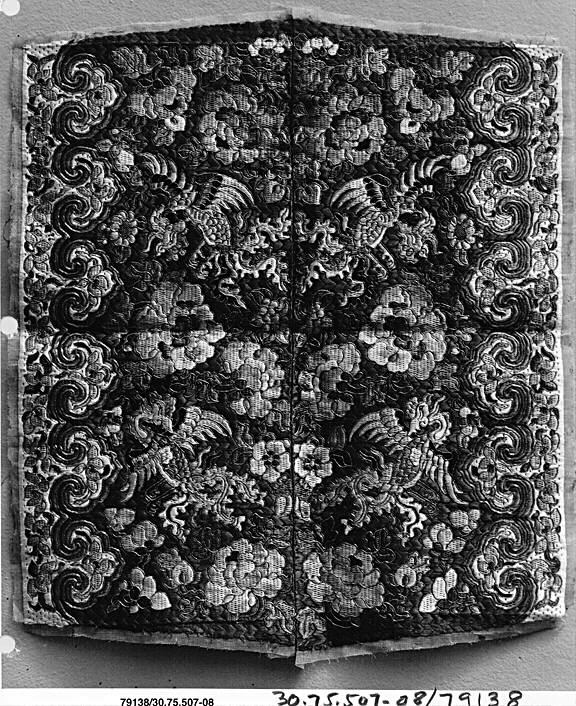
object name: panel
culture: chinese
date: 1801-1900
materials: metal thread, silk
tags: flowers